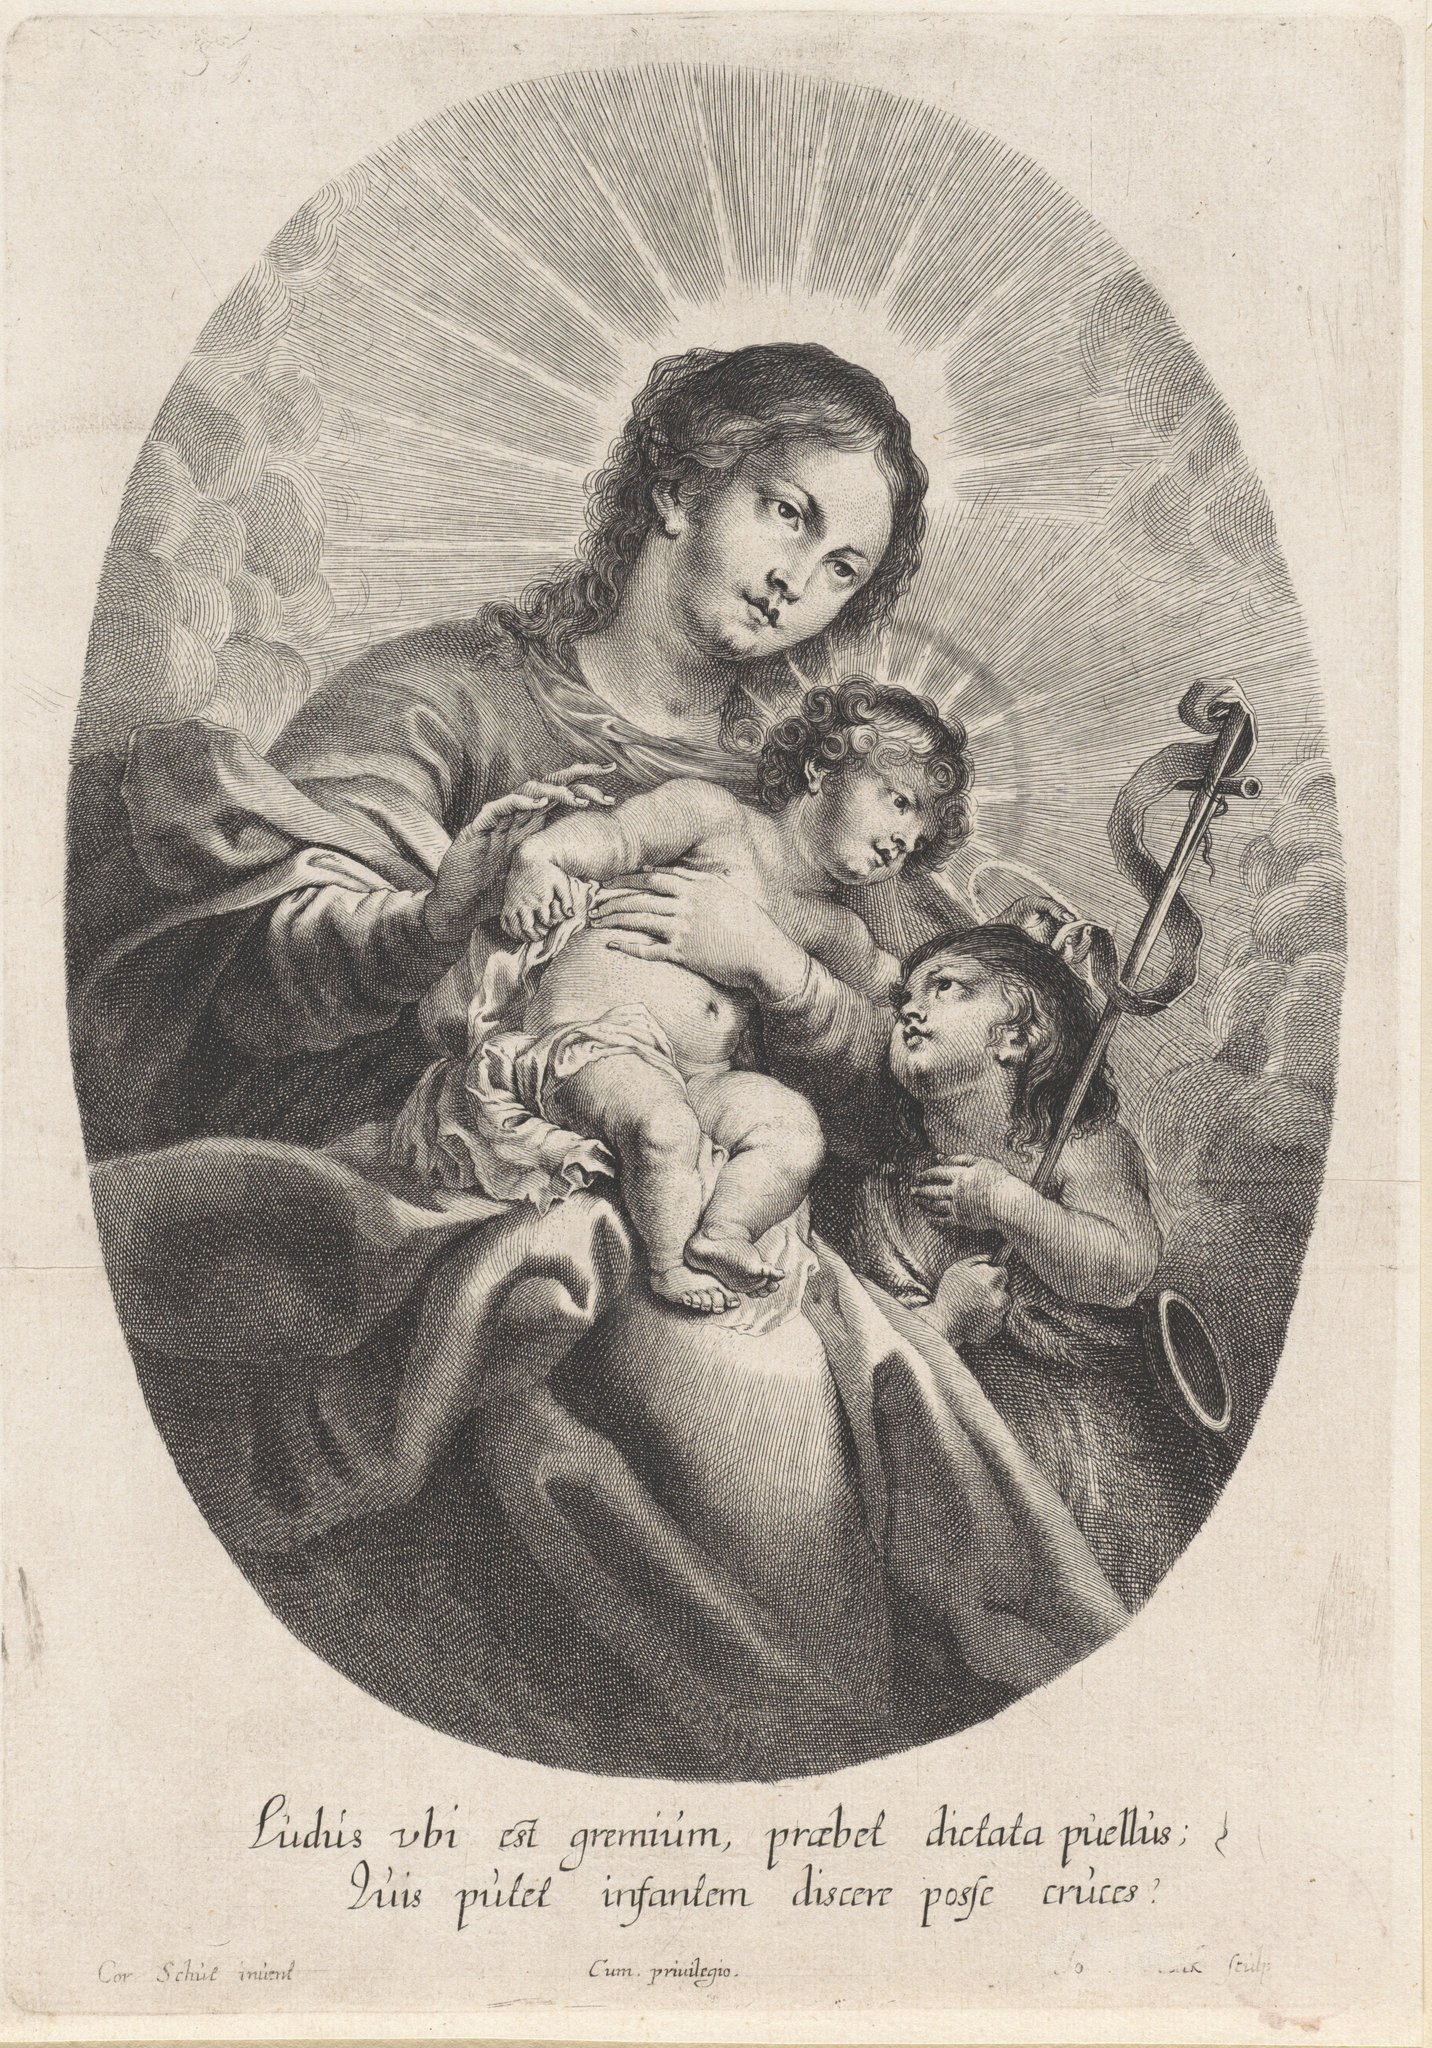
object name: print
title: Maria met Christuskind en Johannes de Doper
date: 1625-1642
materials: paper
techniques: engraving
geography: antwerp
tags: mary and the christ-child with john the baptist (as child)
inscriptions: collector's mark: Lugt 240